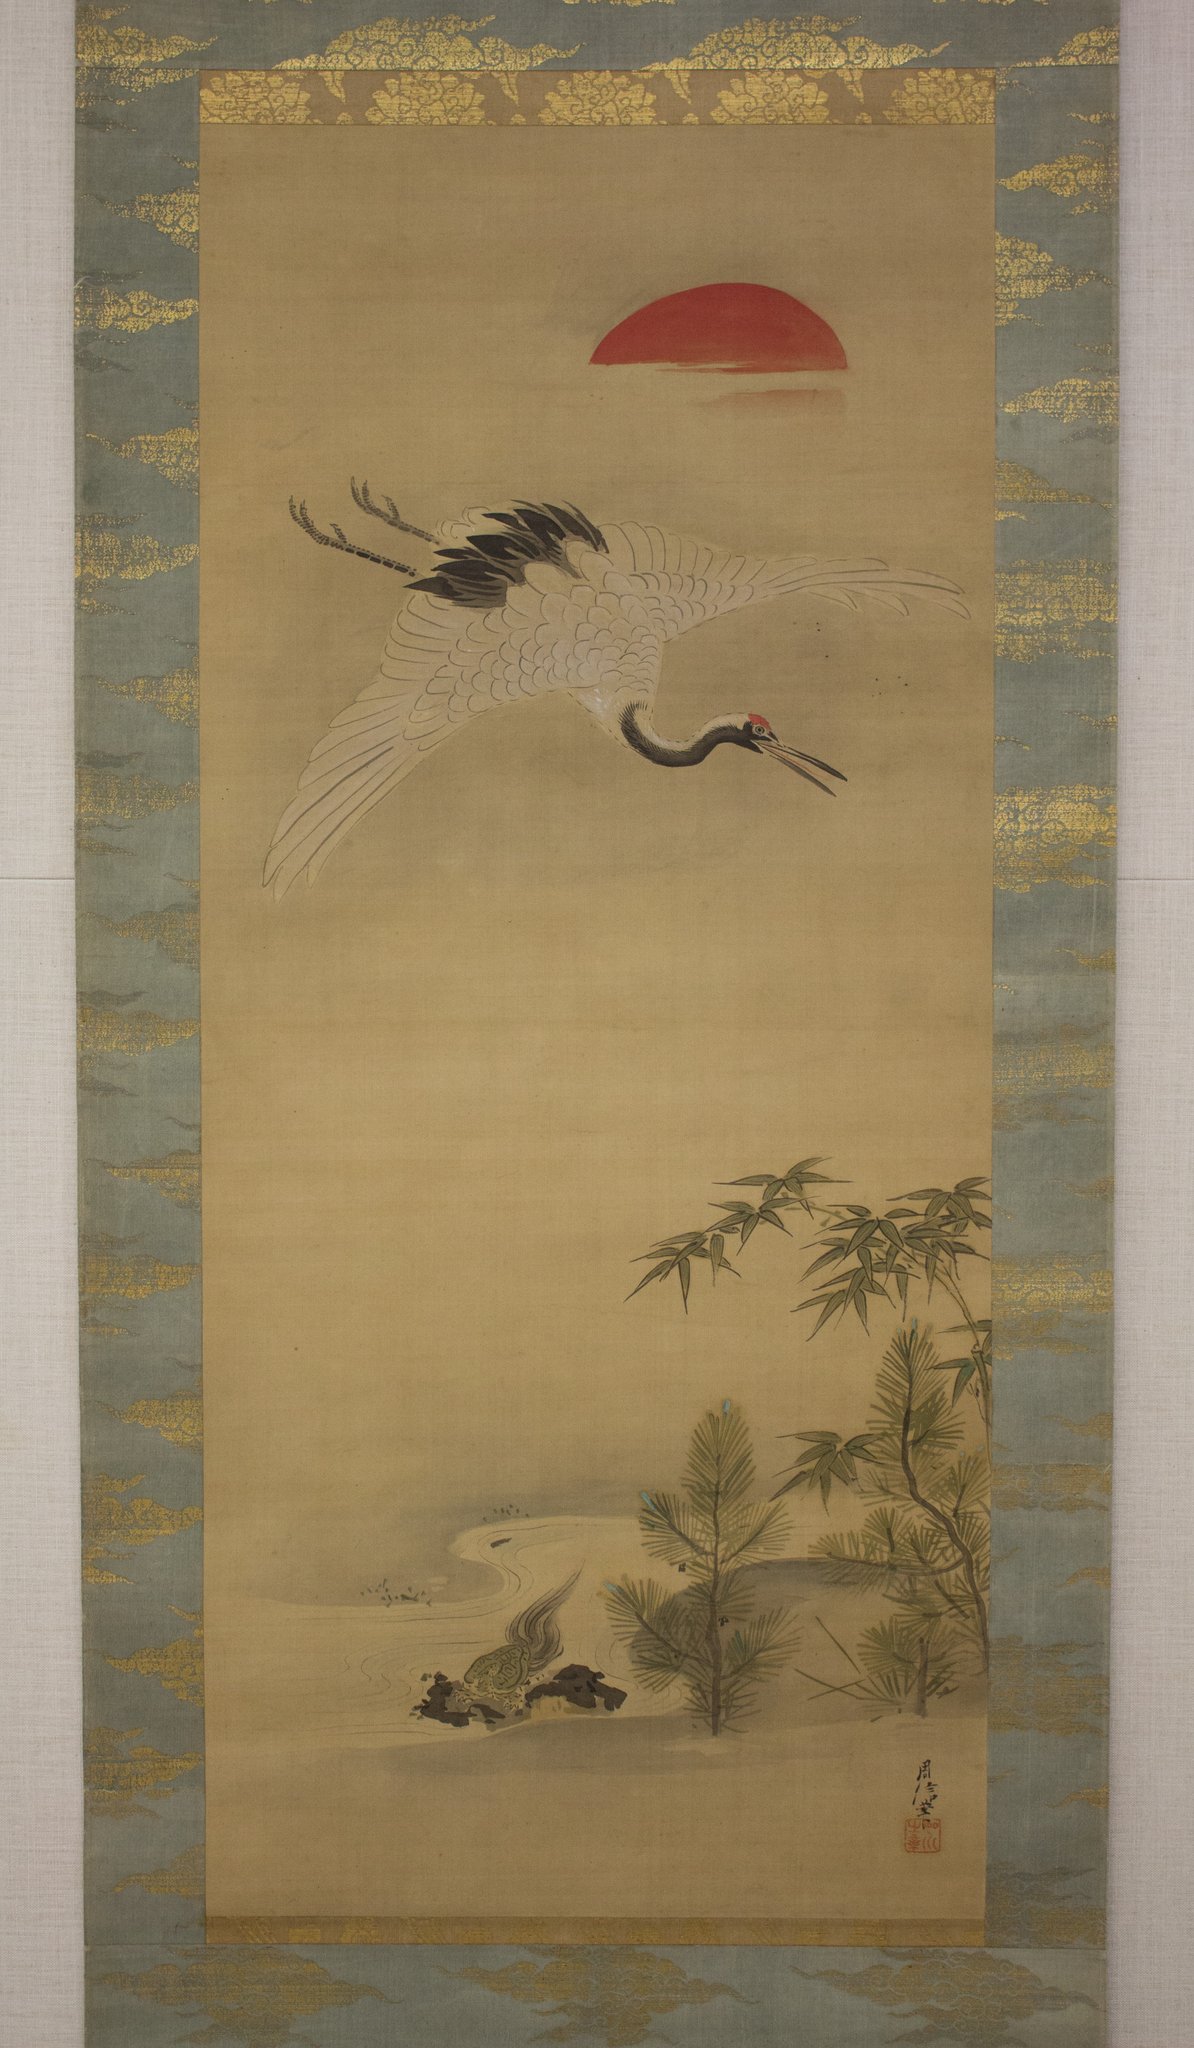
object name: hanging scroll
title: Crane, Tortoise, Pine, and Bamboo under a Rising Sun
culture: japanese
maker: kano chikanobu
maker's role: artist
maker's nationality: japanese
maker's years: 1660-1728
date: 1601-1800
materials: ink, silk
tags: cranes